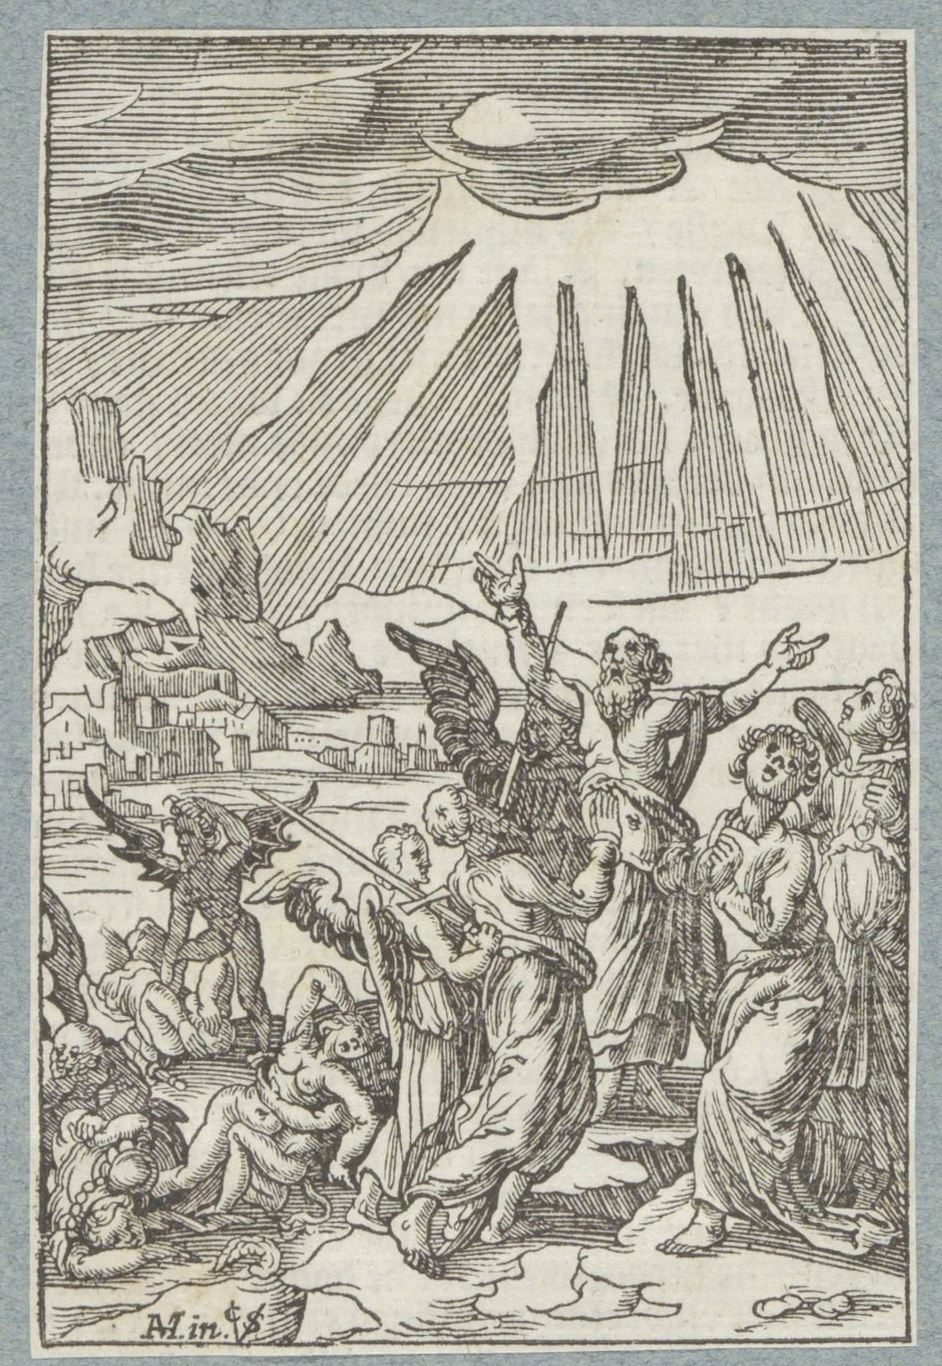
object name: print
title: Red ons uit de greep van het kwaad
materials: paper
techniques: letterpress printing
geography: antwerp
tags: angels rescuing a soul pursued by devils, 'but deliver us from evil' ~ the lord's prayer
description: De prent is afkomstig uit een van de uitgaven van P.J. Paets uit Amsterdam. Ze komt in ieder geval voor in: Het Nieuwe Testament ons Salichmaeckers Jesu Christi. Amsterdam, P.J. Paets, 1646. De voorstelling is gekopieerd naar een prent van Johannes Wierix naar ontwerp van Maarten van Heemskerck, onderdeel van een serie van acht prenten over het Onze Vader.